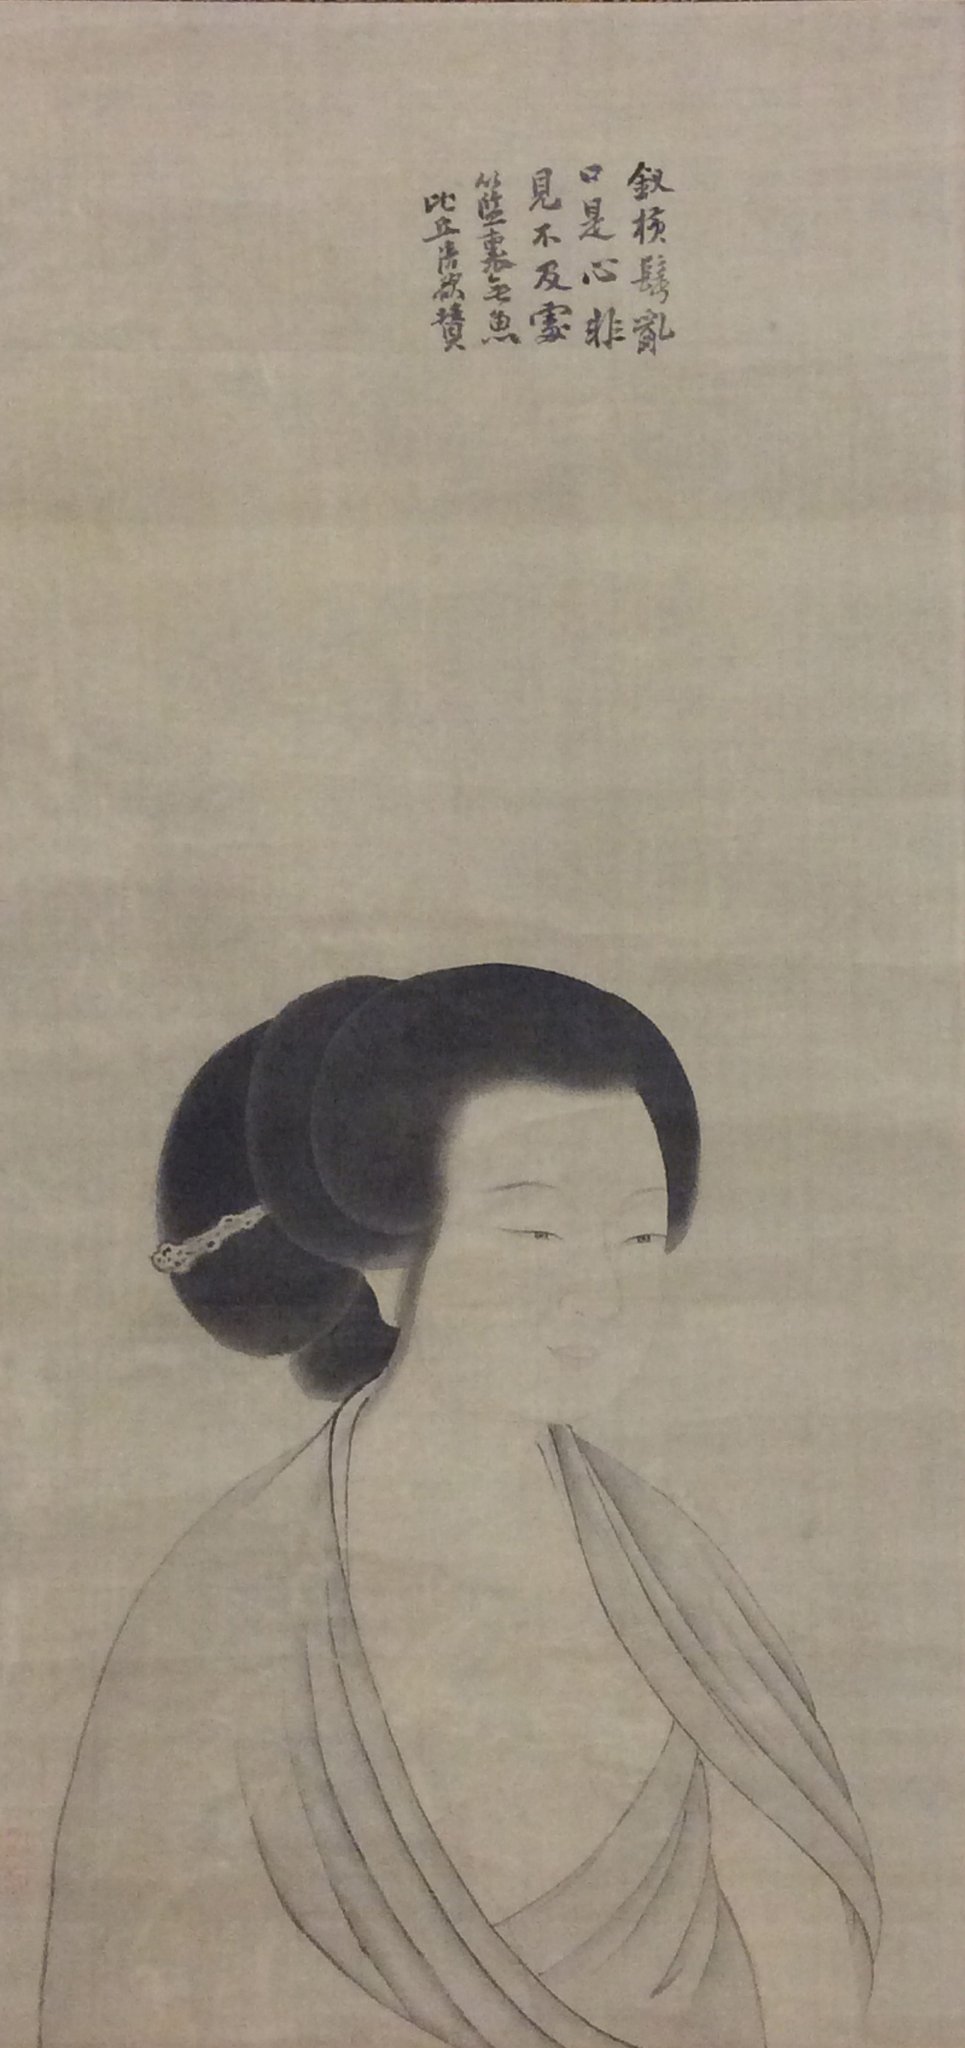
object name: hanging scroll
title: Portrait of Lady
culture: japanese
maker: kano tanbi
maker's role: artist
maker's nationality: japanese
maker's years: 1840-1893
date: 1867-1900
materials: ink, paper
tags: portraits,women